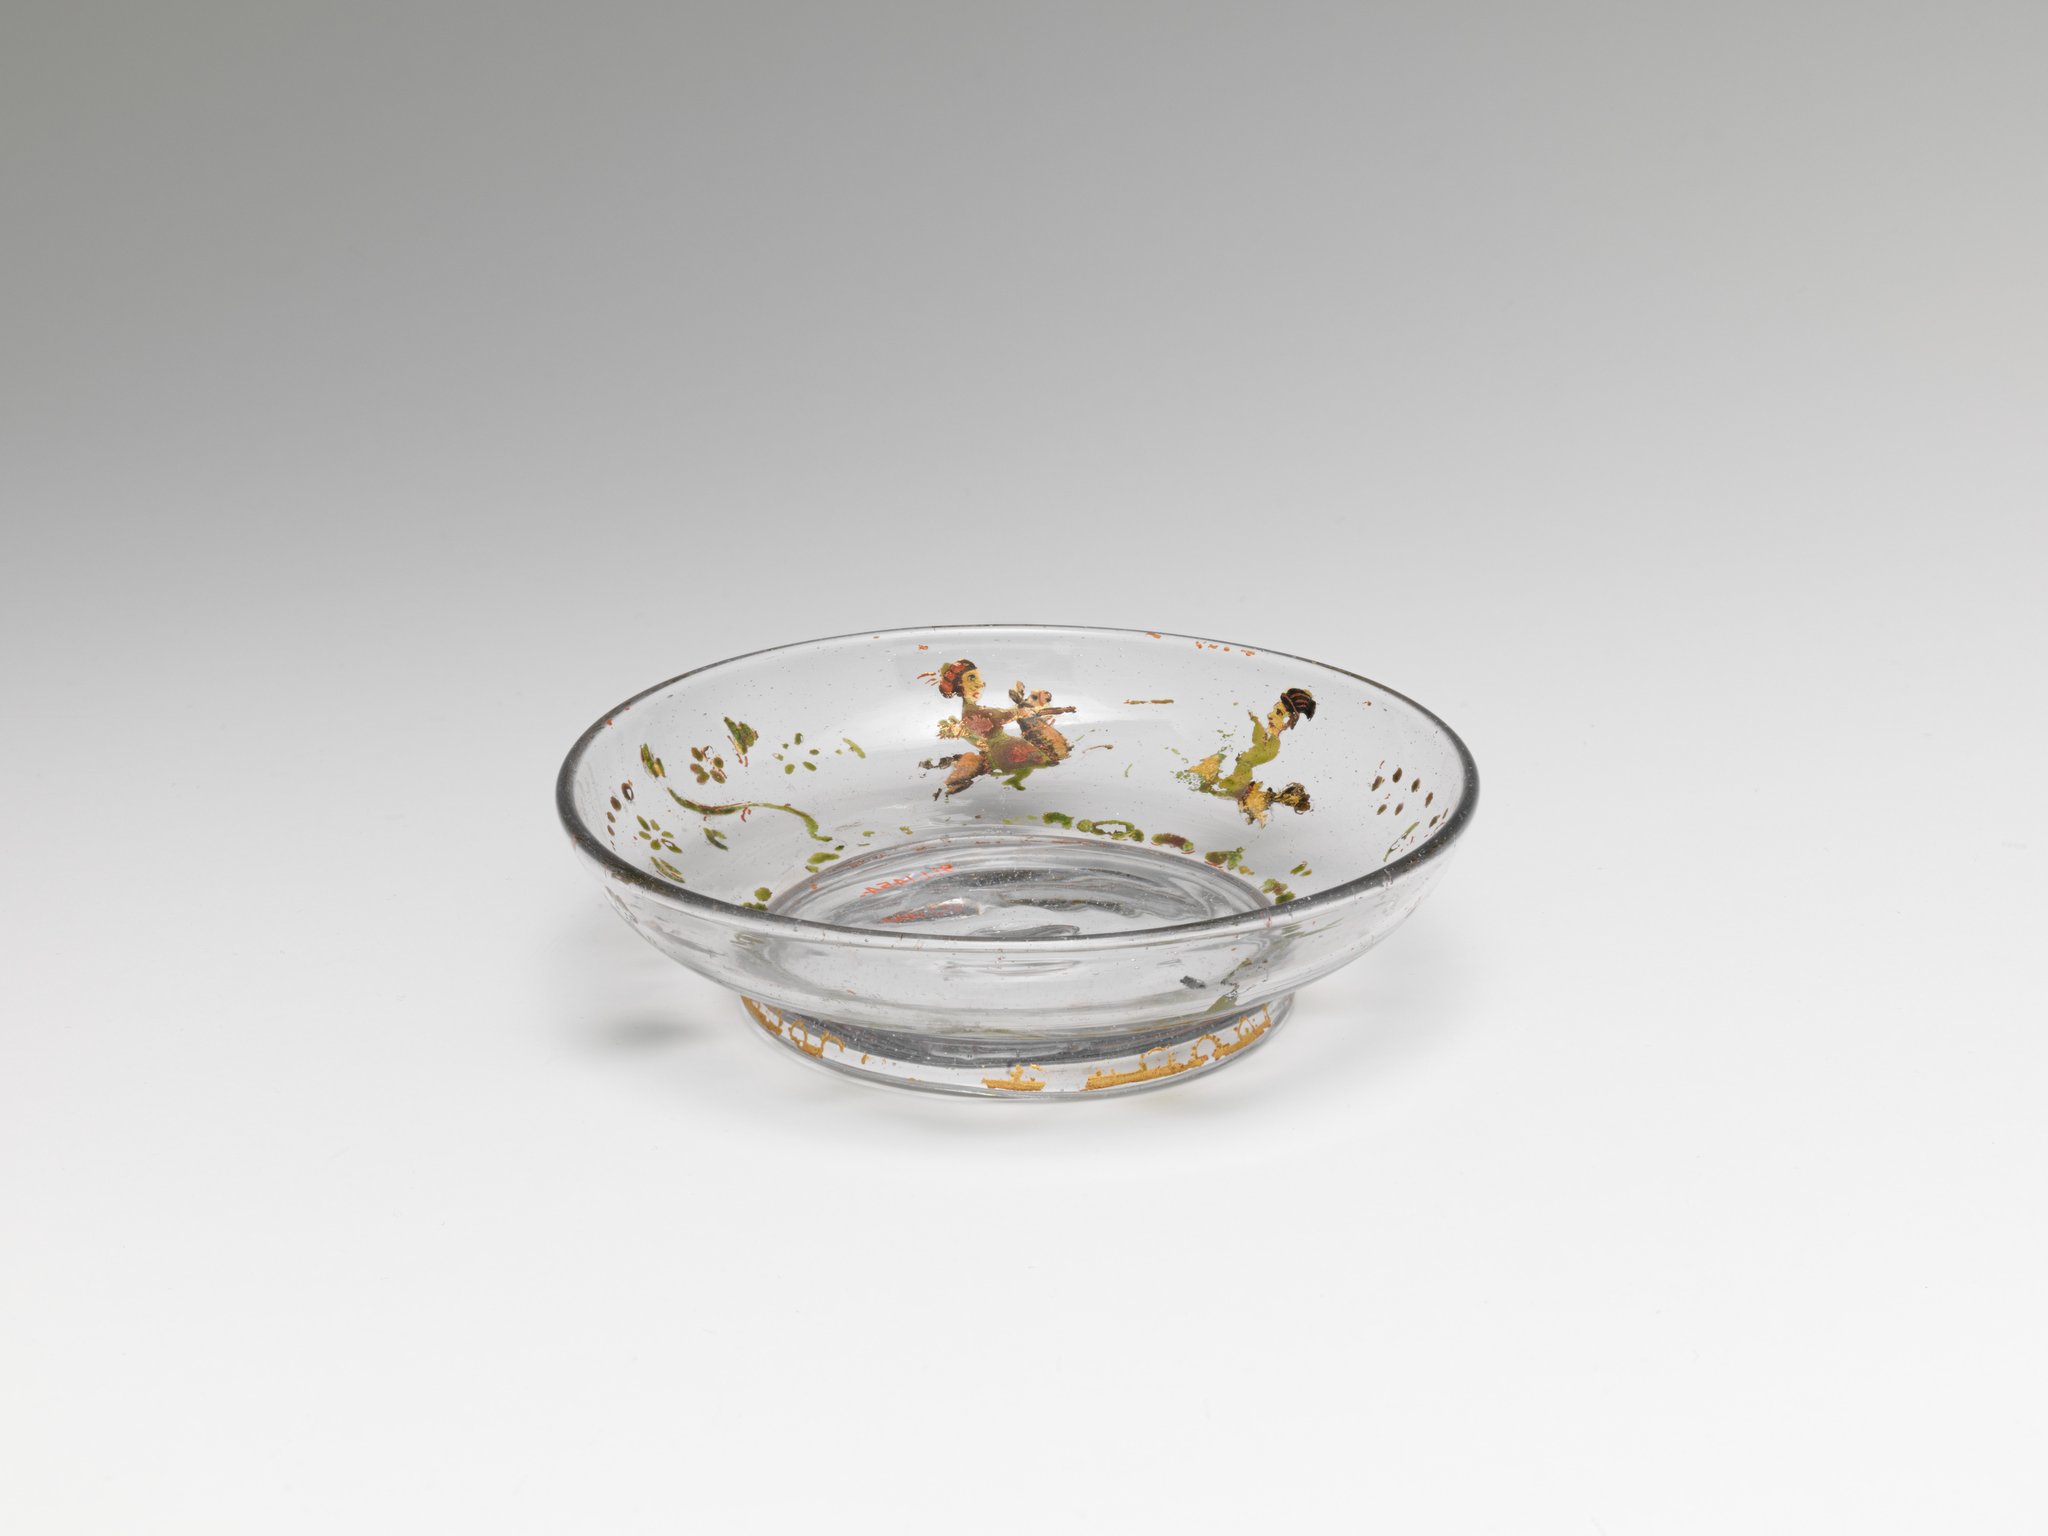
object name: saucer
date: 1730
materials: glass